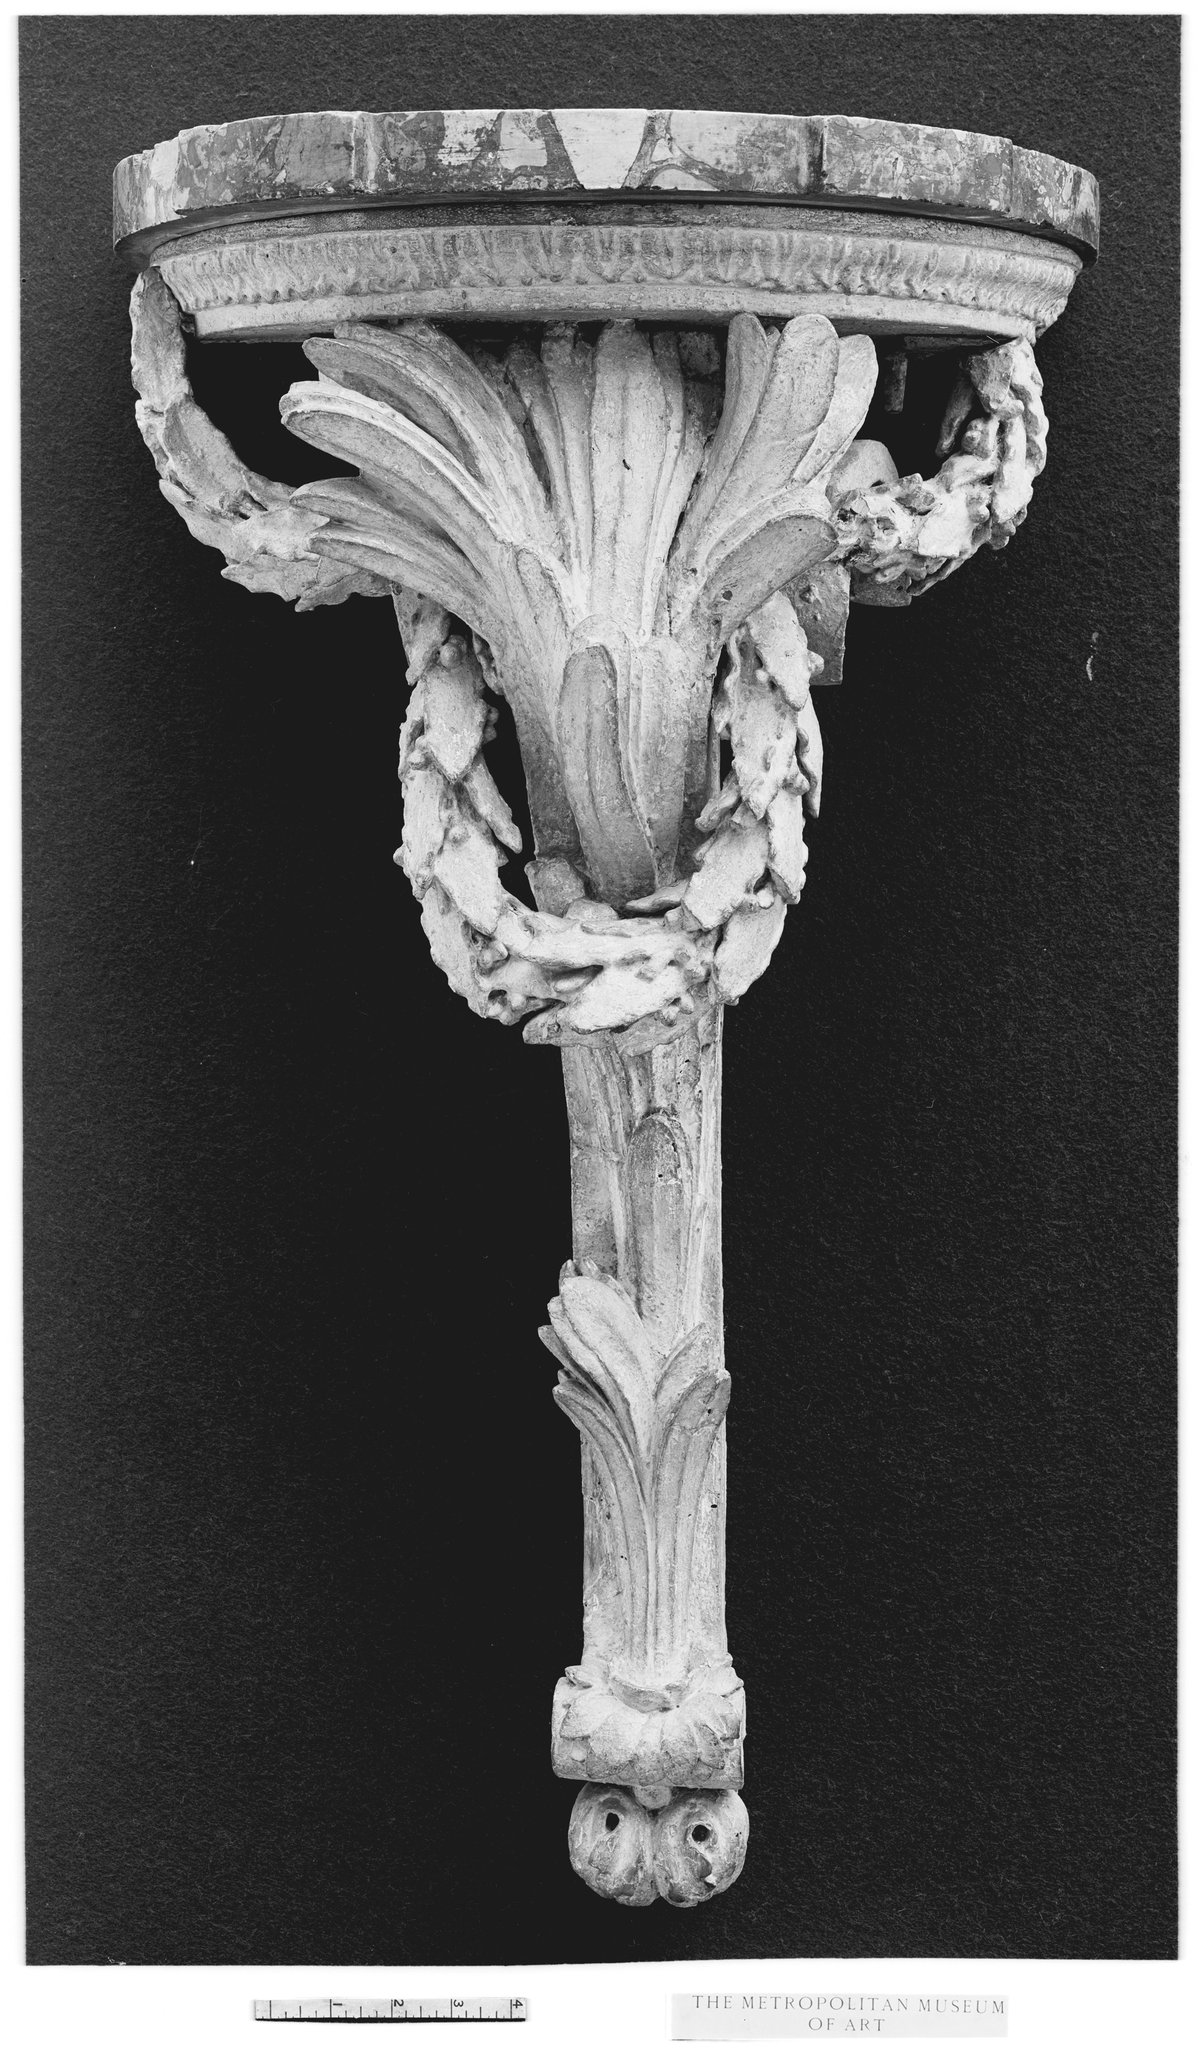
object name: console table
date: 1701-1800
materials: marble, wood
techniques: carving, painting